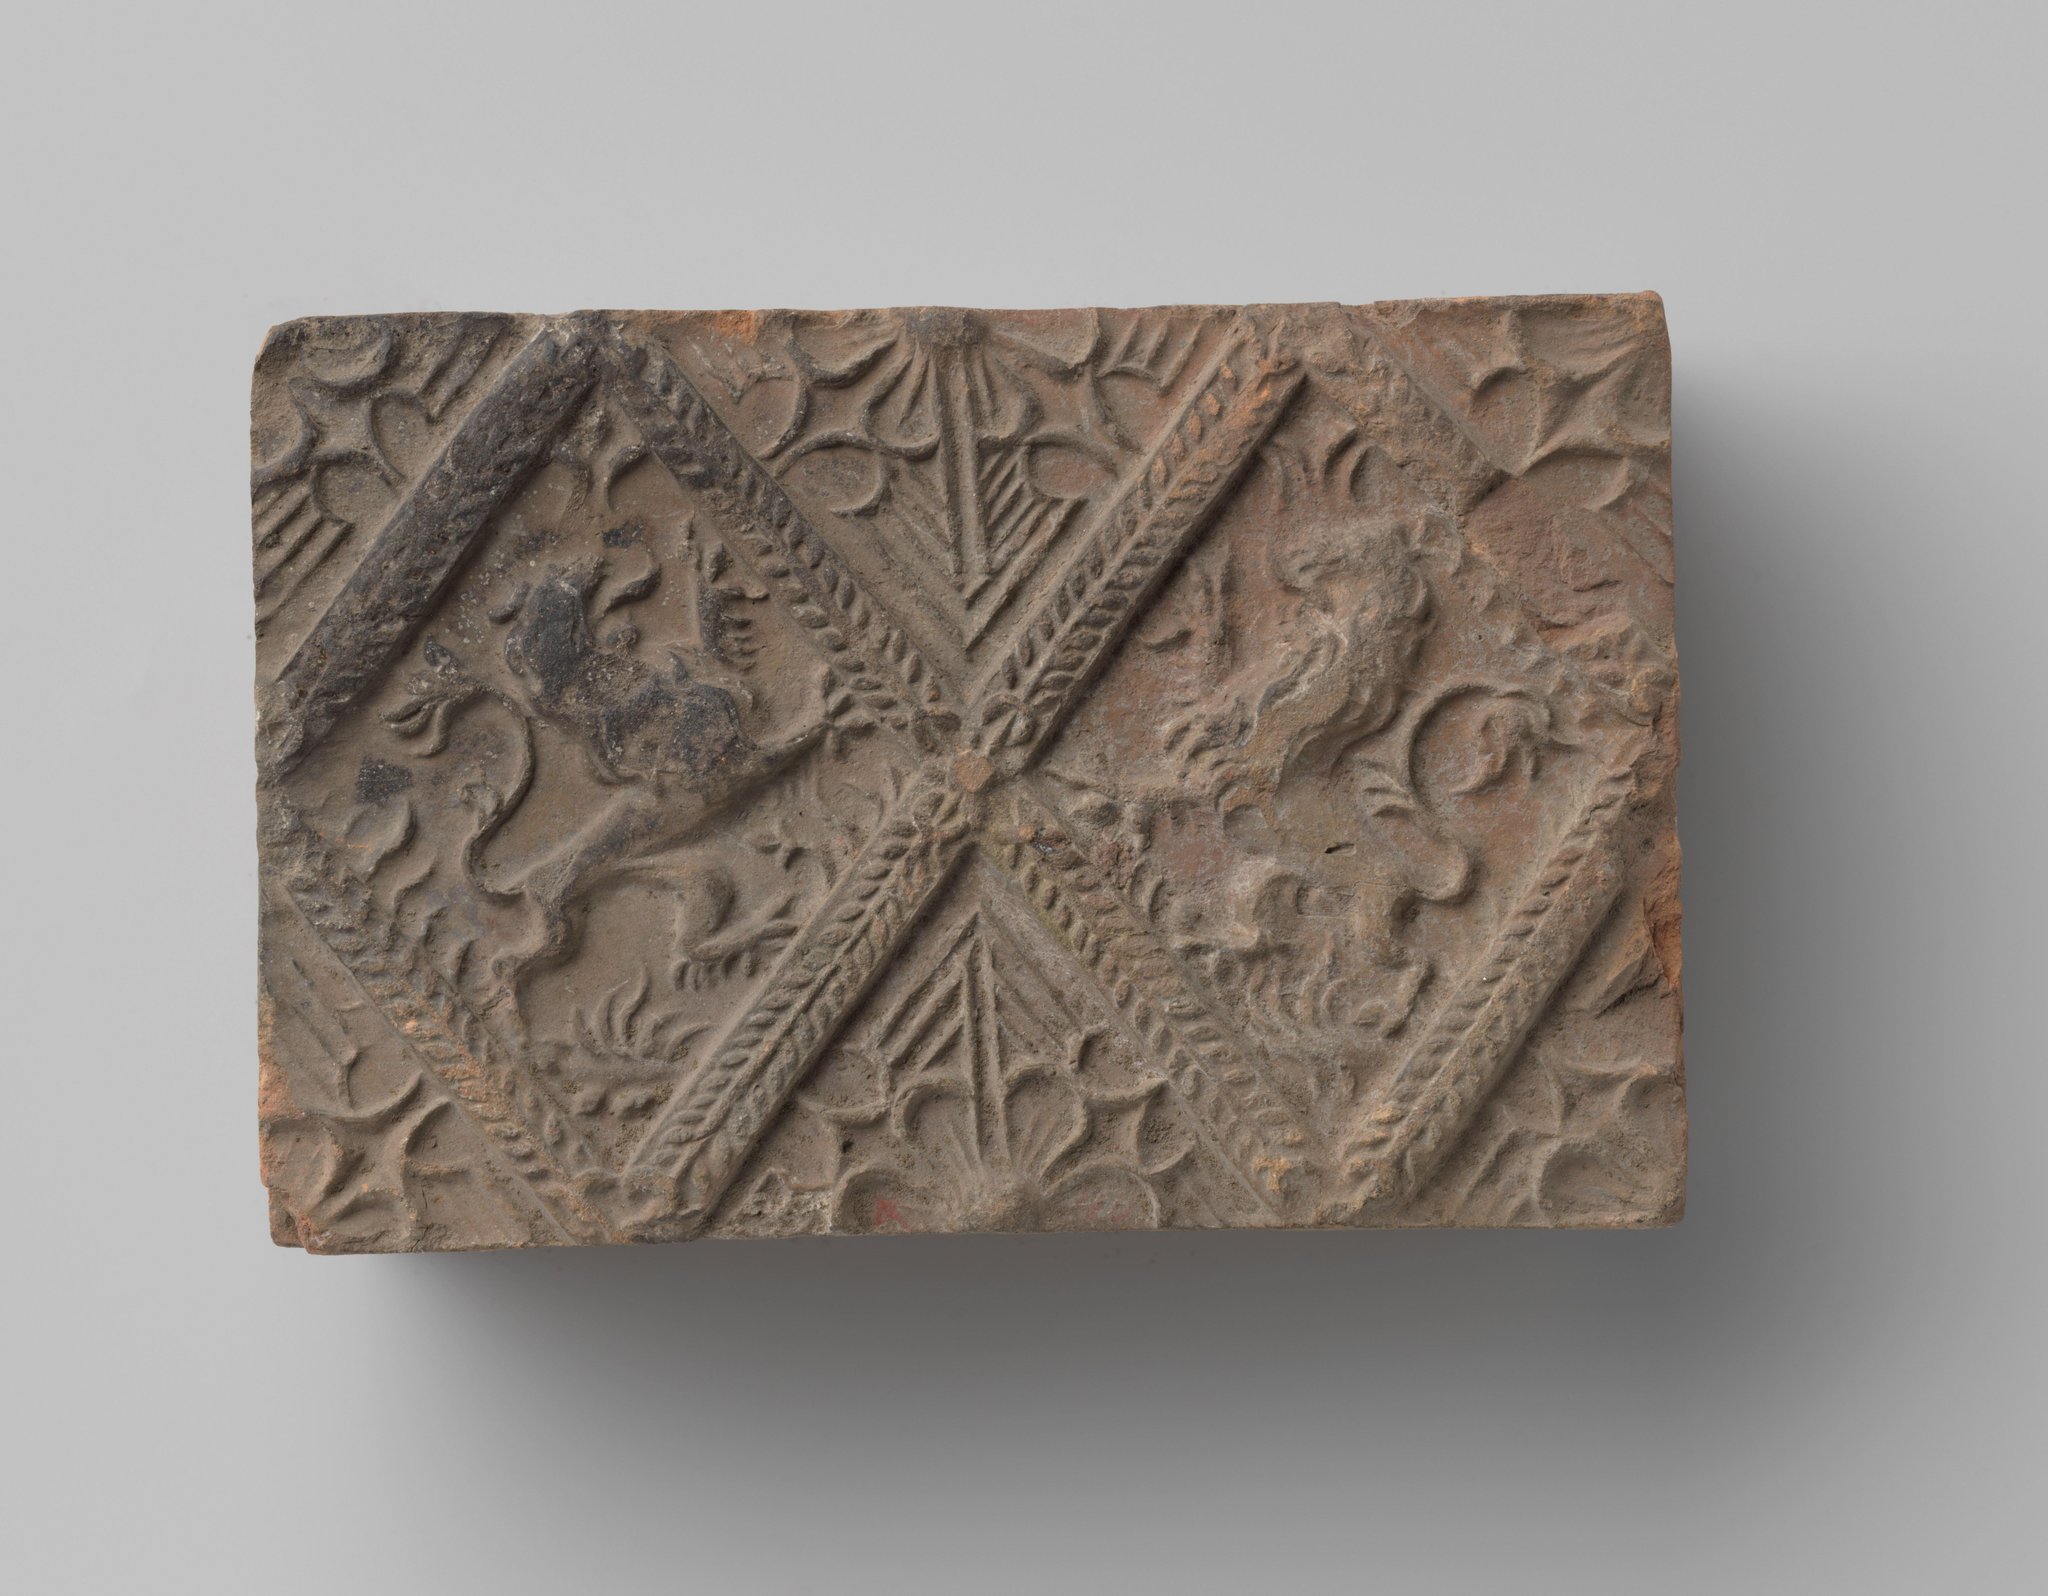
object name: hearthstone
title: Haardsteen met voorstelling van twee klimmende leeuw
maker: Anonymous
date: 1600-1625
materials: earthenware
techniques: printing, firing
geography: southern netherlands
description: Haardsteen met voorstelling van twee naar elkaar toegewende leeuwen, geplaatst in geprofileerde ruit. De halve ruiten aan de boven- en onderkant zijn opgevuld met halve medaillons met pijlmotief.